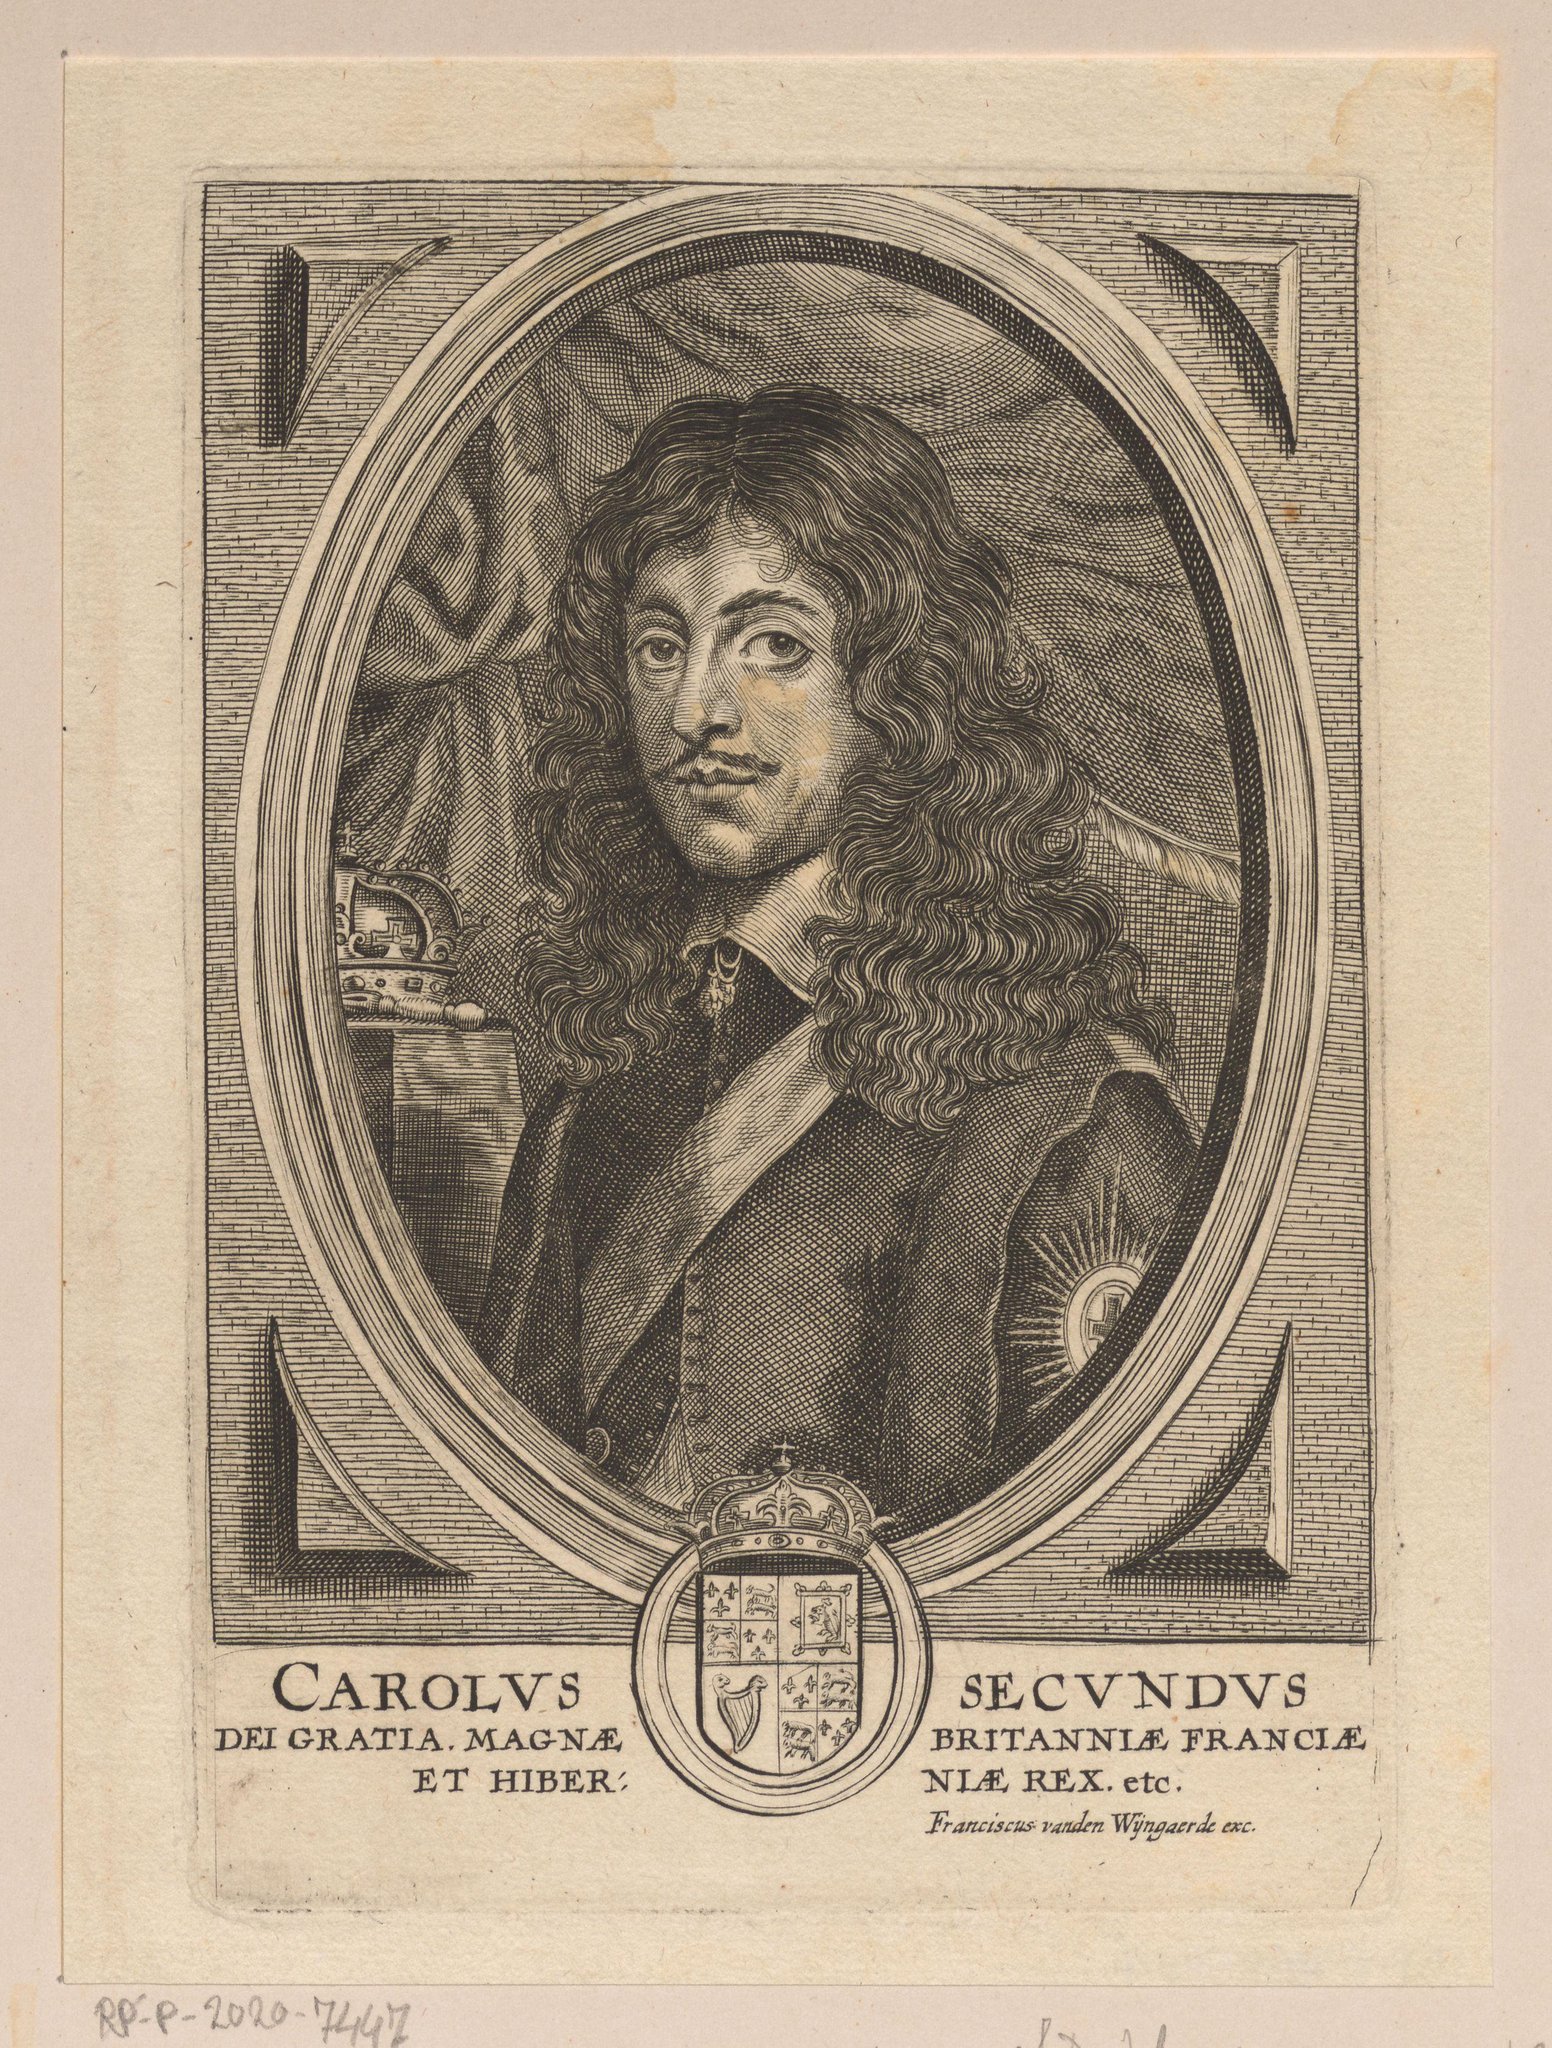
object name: print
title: Portret van Karel II, koning van Engeland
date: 1660-1679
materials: paper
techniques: engraving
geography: antwerp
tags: london, karel ii (koning van engeland), historical persons, king, armorial bearing, heraldry